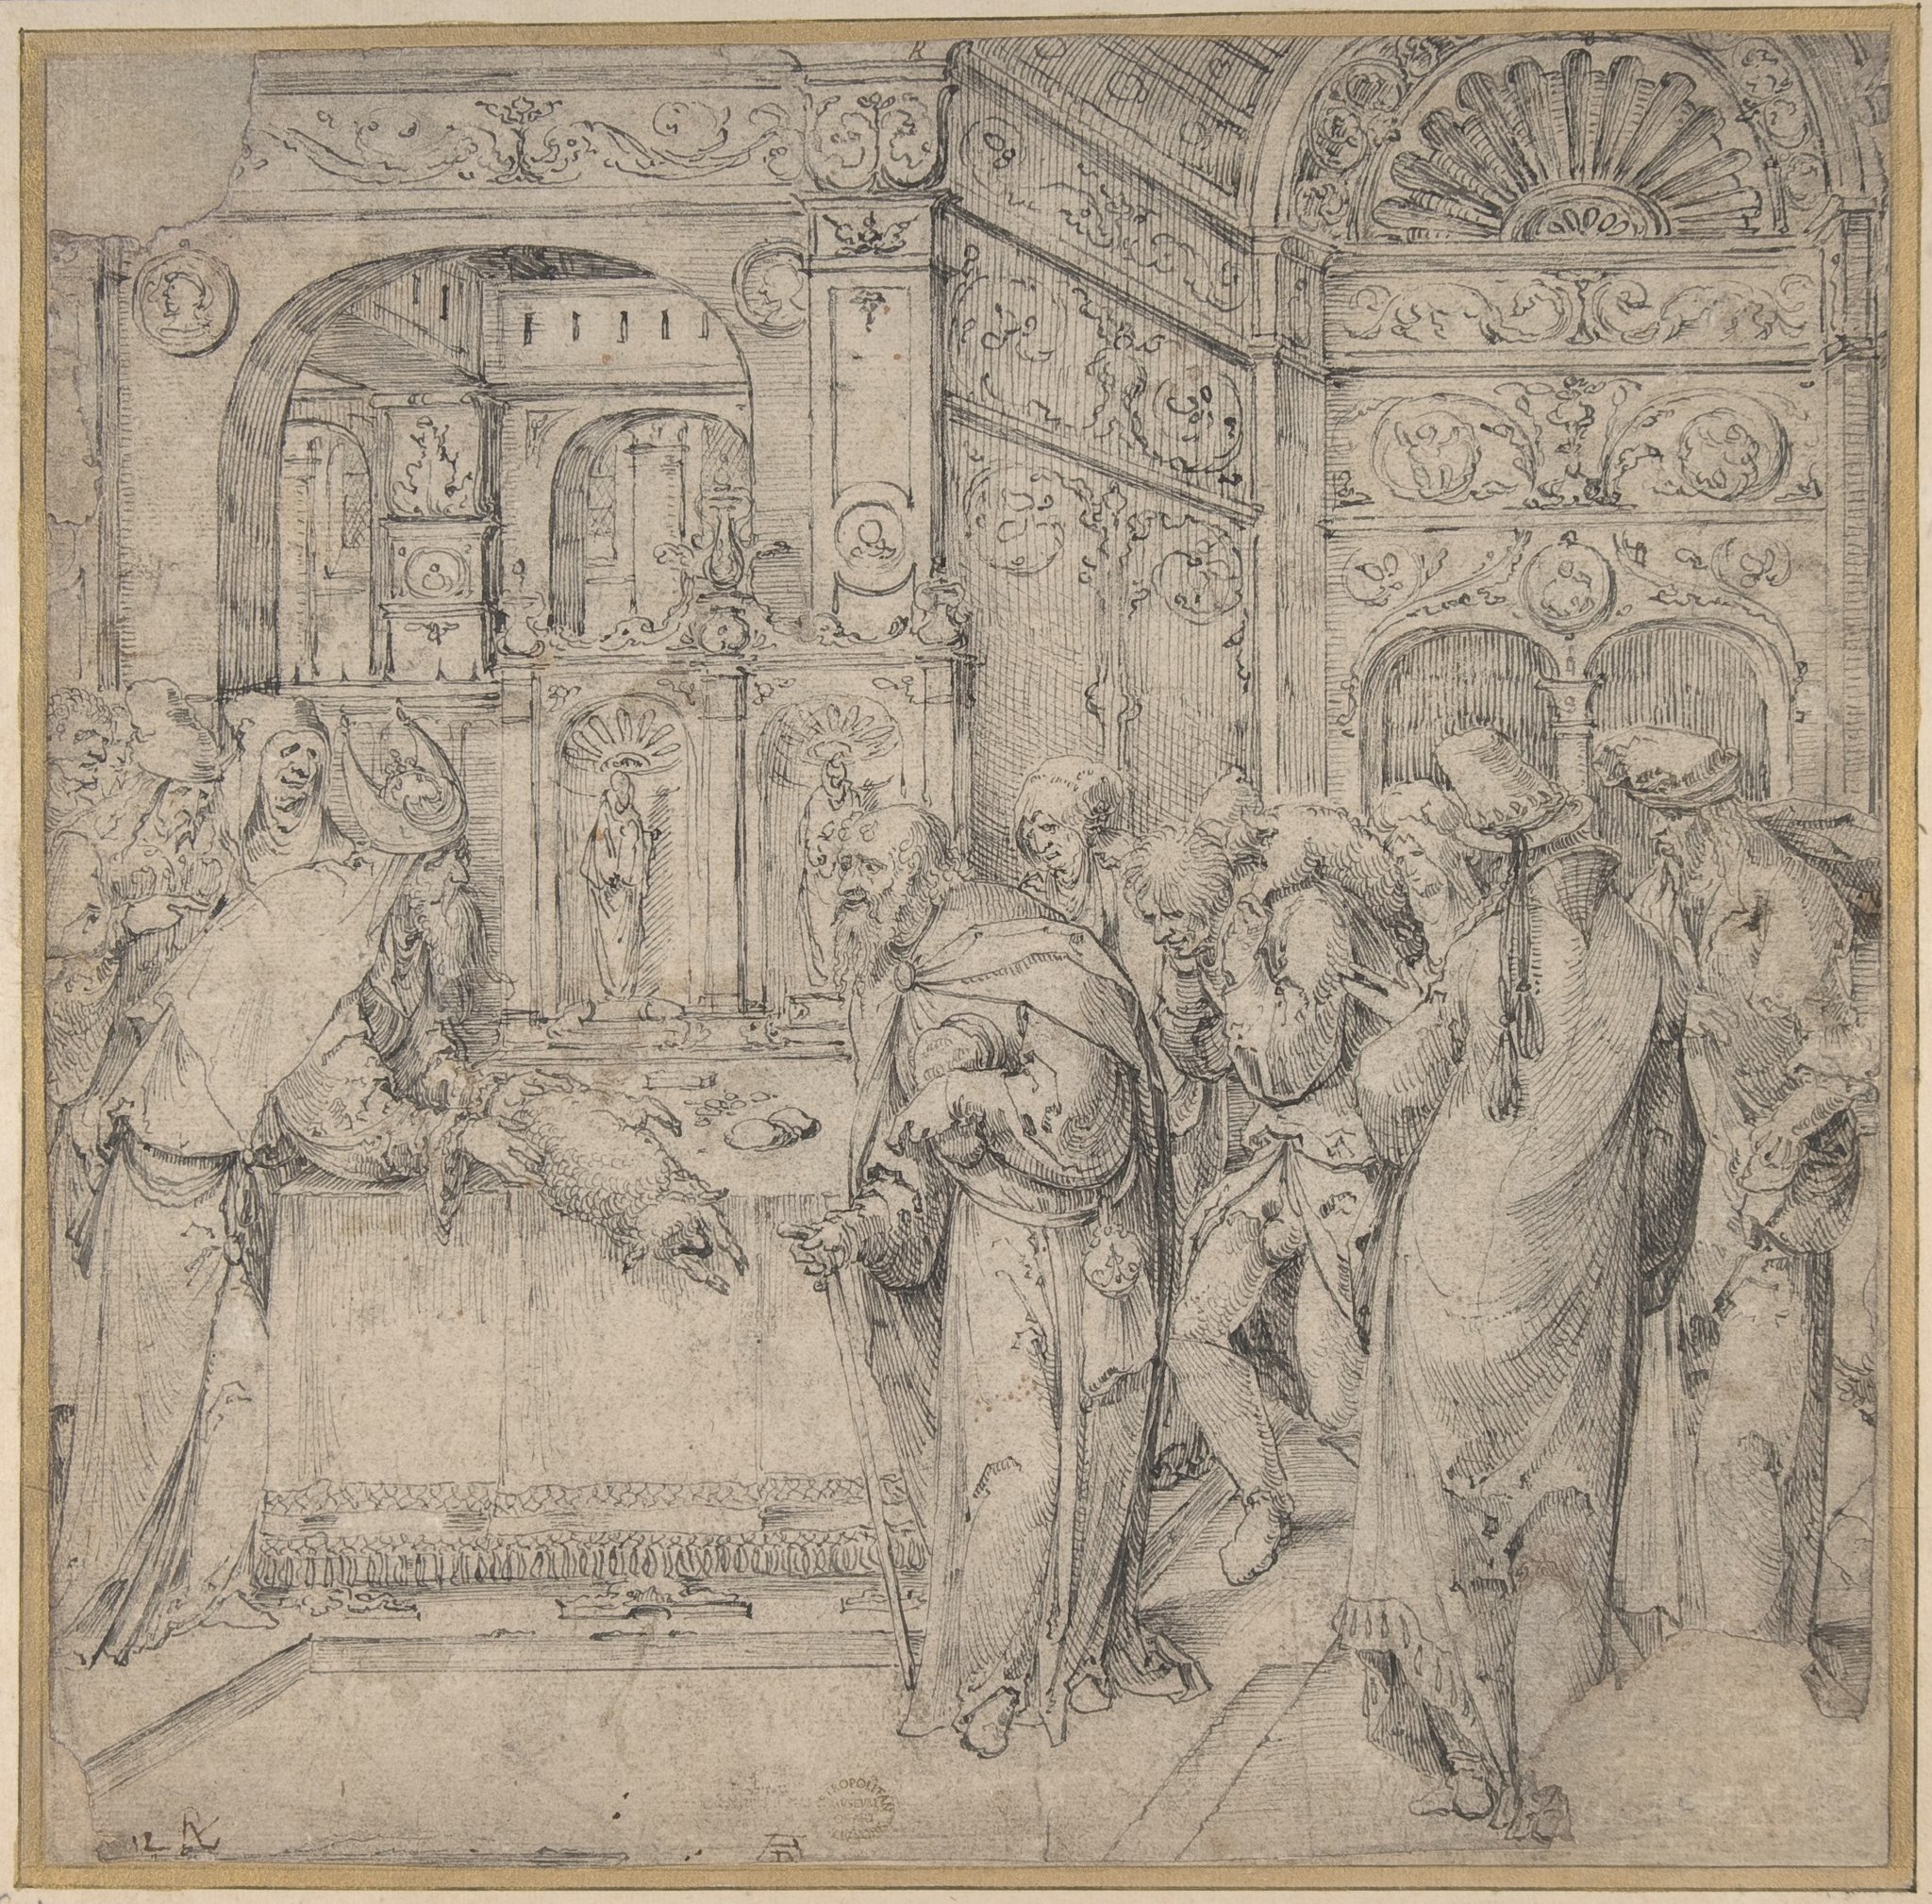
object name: drawing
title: Joachim's Offering Refused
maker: jan wellens de cock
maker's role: artist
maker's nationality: netherlandish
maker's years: 1480-1527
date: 1501-1533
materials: ink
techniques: pen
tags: animals,interiors,men,saints,crowd